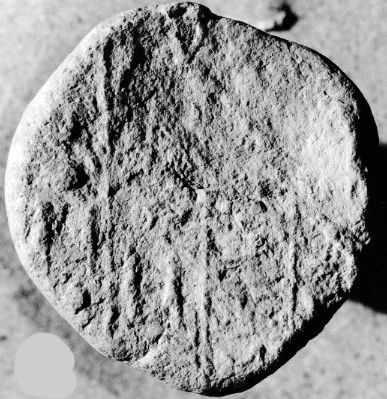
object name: cone, circular impression, meryremetjef, sailor, amun, mut, house mistress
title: Funerary Cone of Meryremetjef (Mery-remetjef) and His Wife Mut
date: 1550-1295 BCE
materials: pottery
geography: egypt